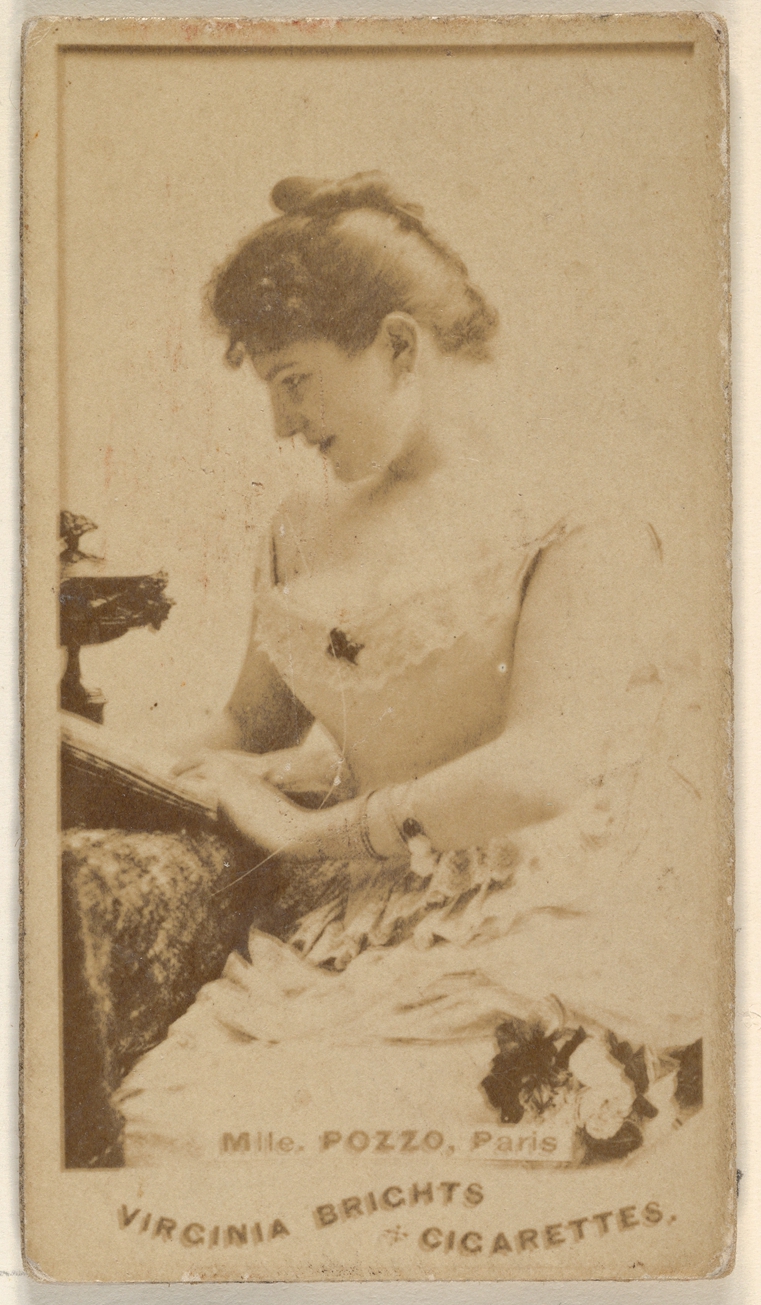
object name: photograph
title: Mlle. Pozzo, Paris, from the Actors and Actresses series (N45, Type 1) for Virginia Brights Cigarettes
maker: allen & ginter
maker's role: publisher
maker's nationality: american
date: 1888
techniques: albumen silver print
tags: portraits,women,actresses